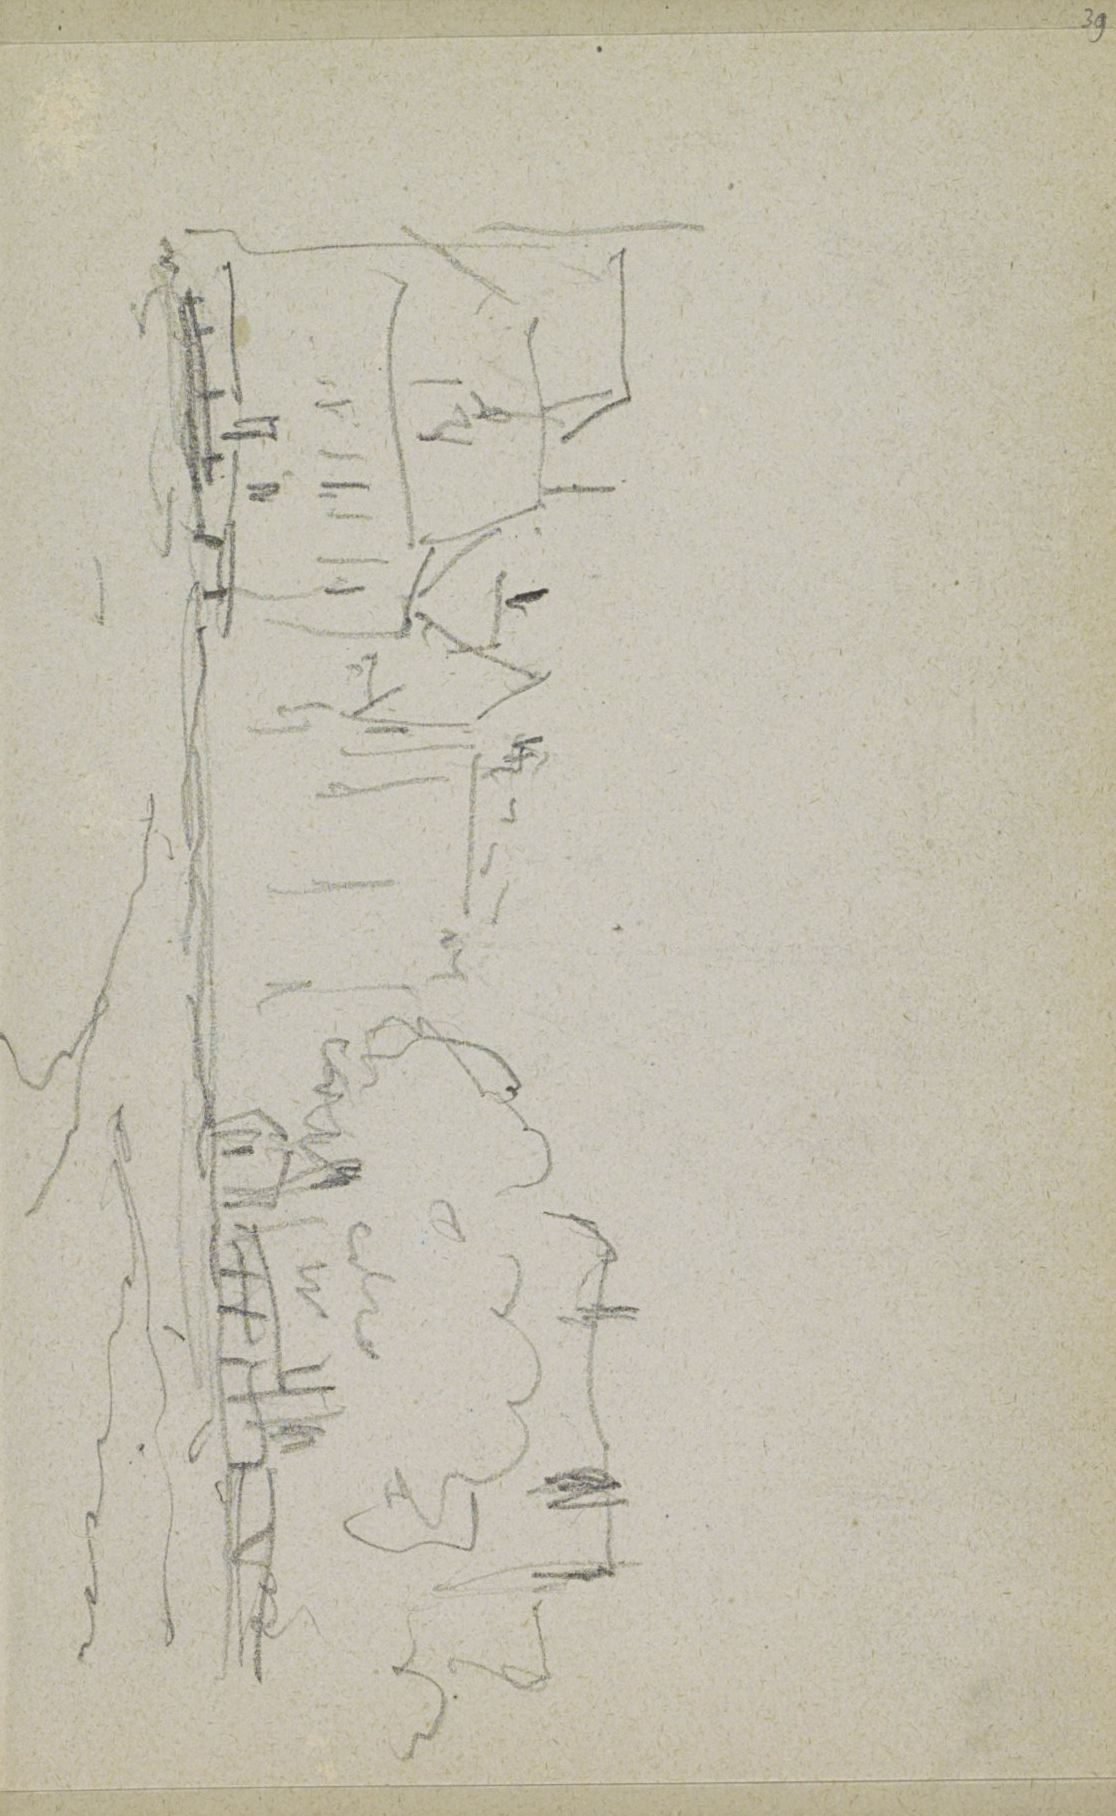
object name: sketchbook leaf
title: Gezicht op gebouwen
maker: adrianus eversen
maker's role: draughtsman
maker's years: 1818-1897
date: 1828-1897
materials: paper, pencil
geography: netherlands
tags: civic architecture; edifices; dwellings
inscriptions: kleurnotitie, handgeschreven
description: Gezicht op gebouwen aan weerszijden van een weg of water. Blad 39 recto uit een schetsboek met 58 bladen.